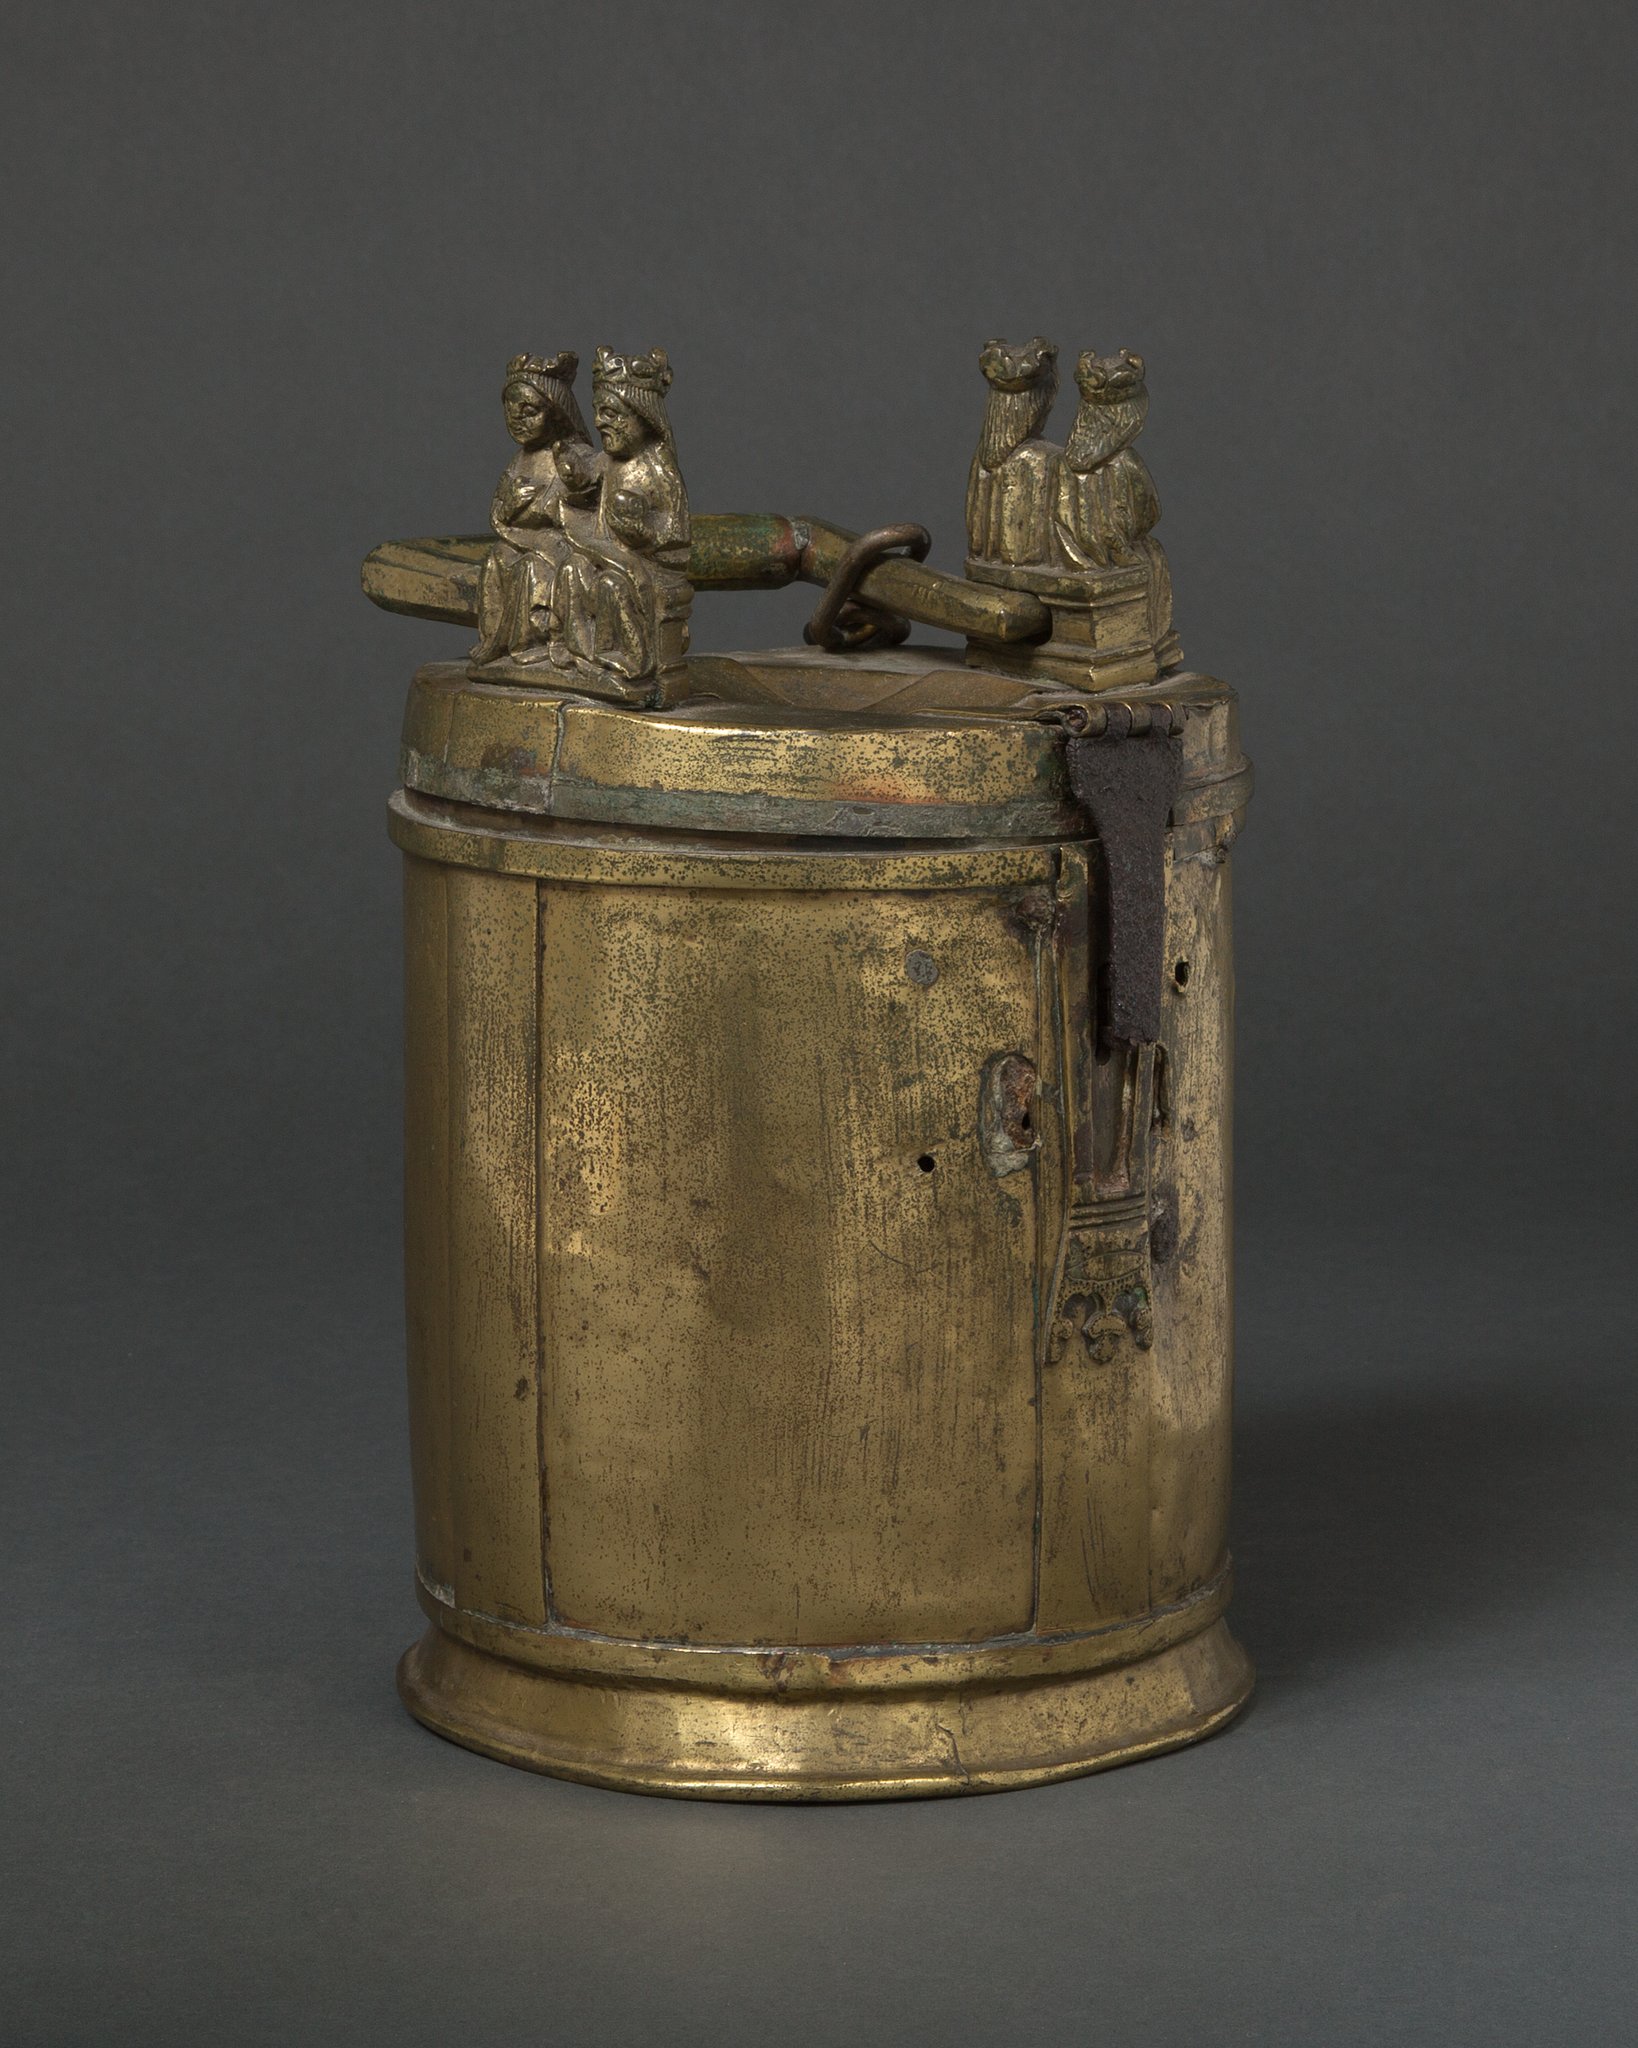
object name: alms box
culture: south netherlandish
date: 1401-1500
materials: brass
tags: men,women